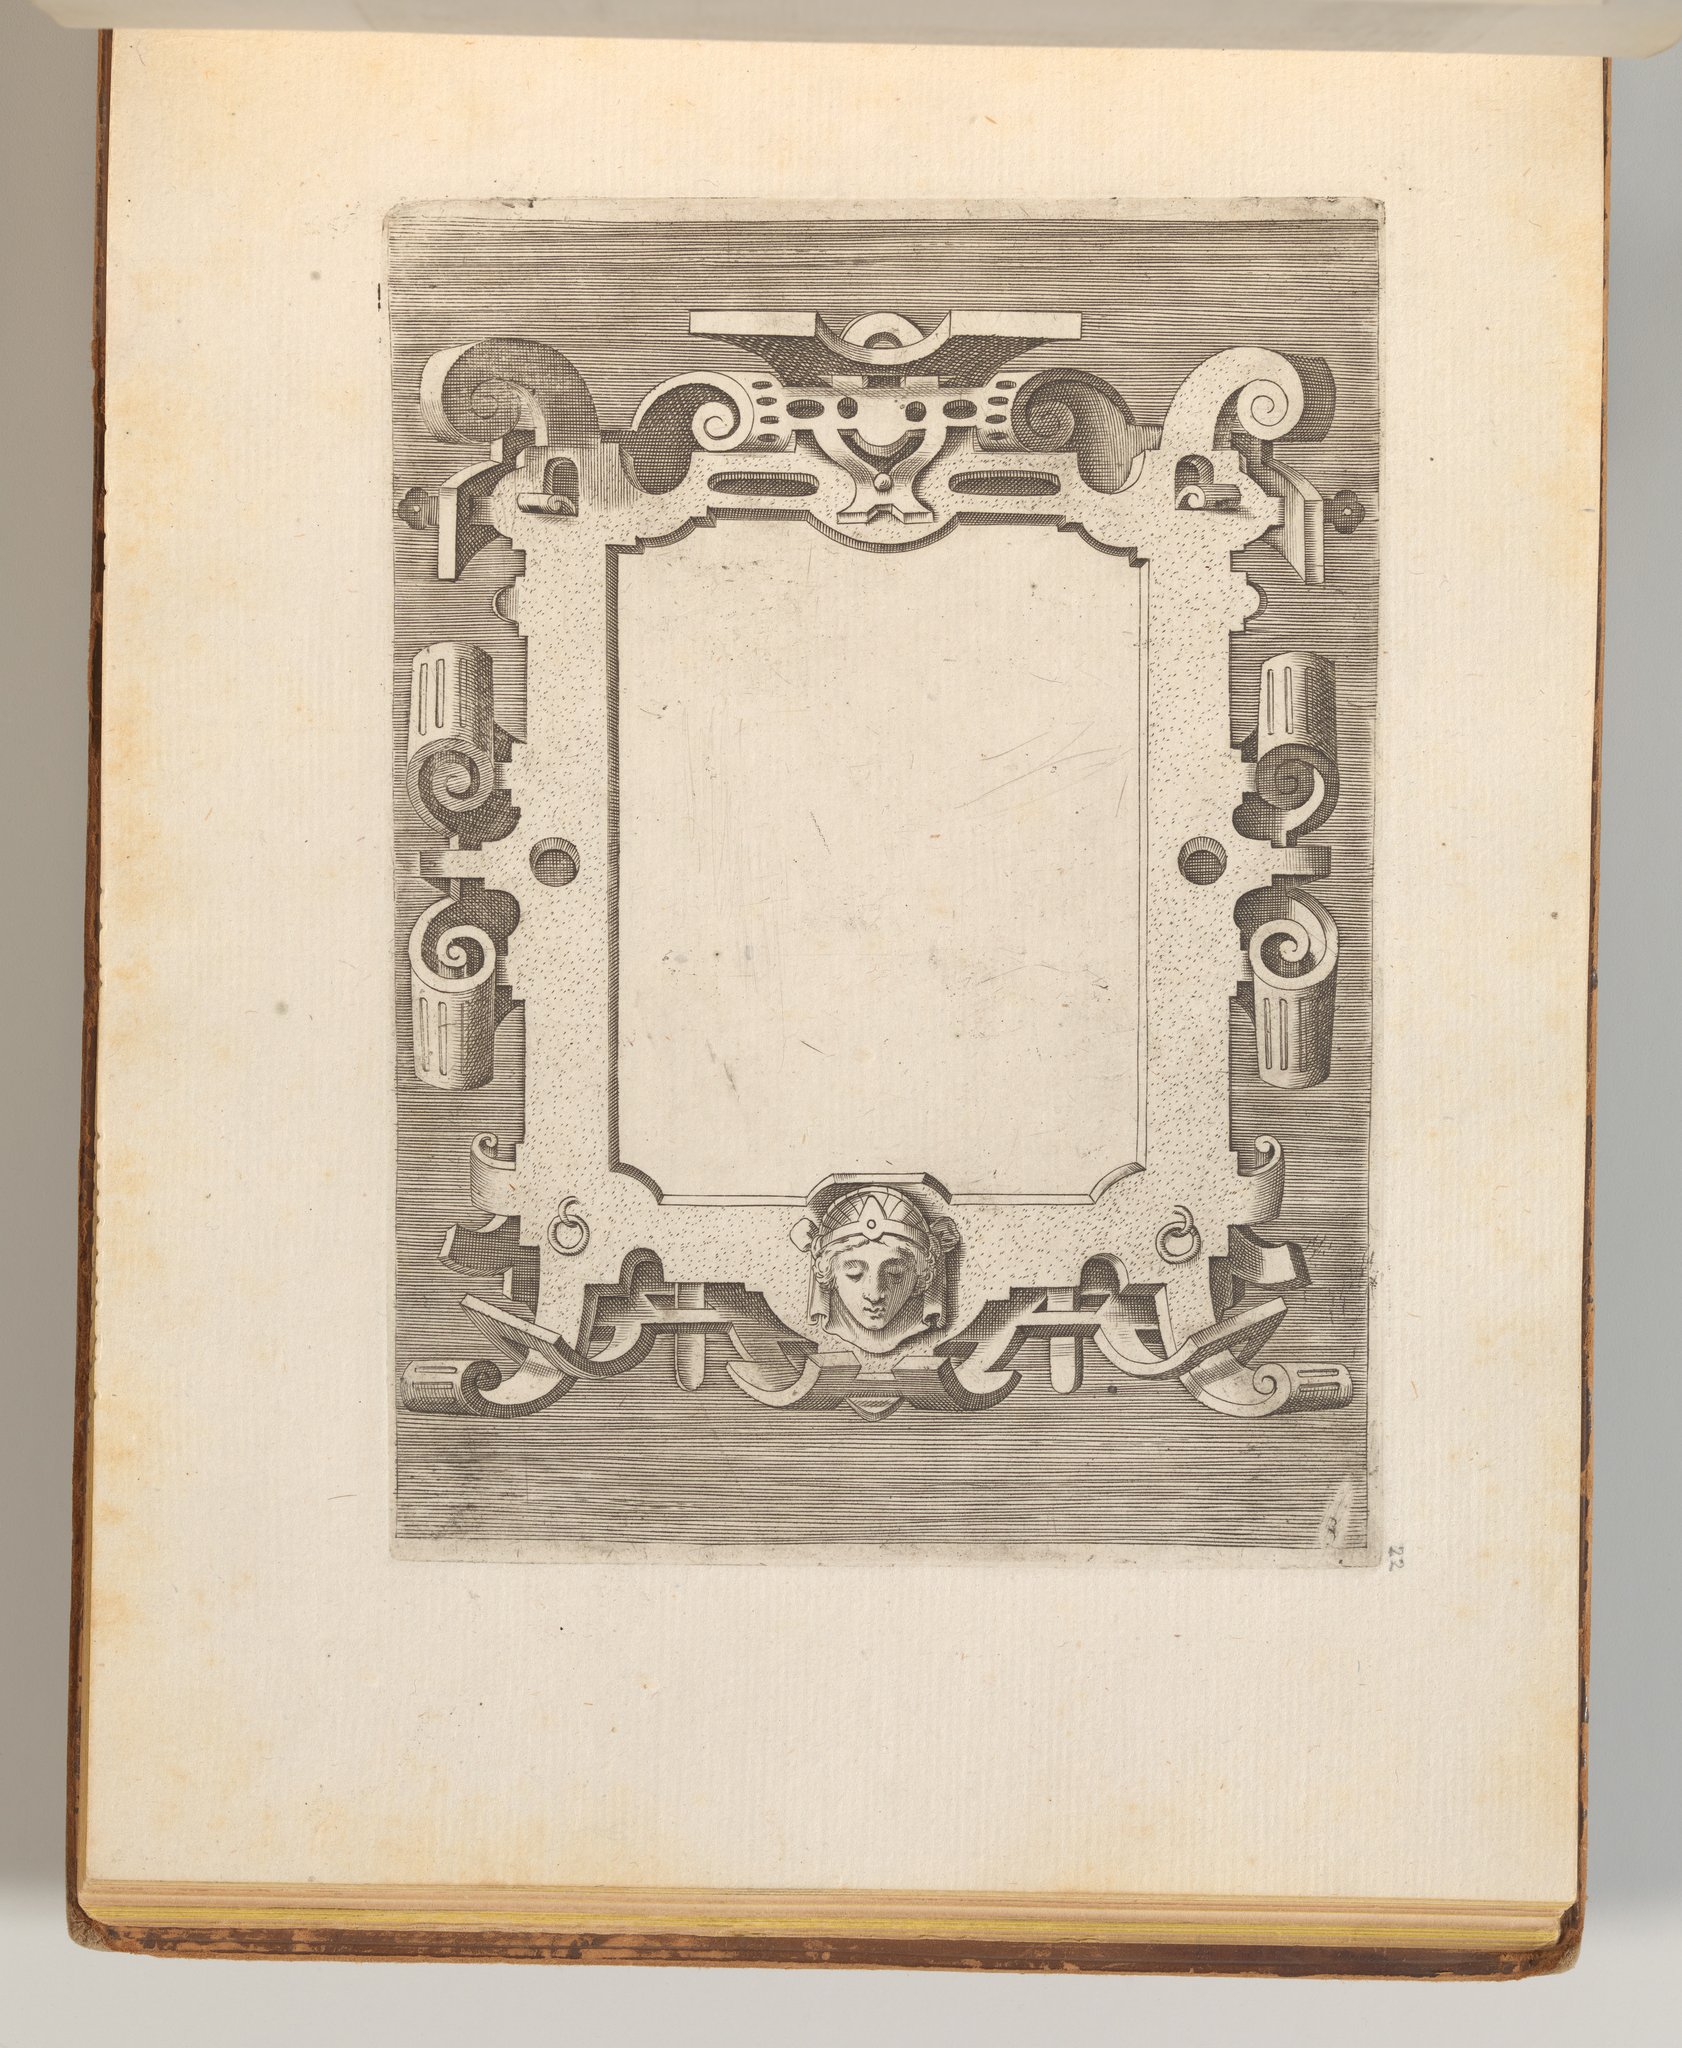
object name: album print ornament architecture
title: Targhe ed altri ornati di varie e capricciose invenzioni (Cartouches and other ornaments of various and capricious invention, page 27)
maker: hans vredeman de vries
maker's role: artist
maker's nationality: netherlandish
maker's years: 1527-1606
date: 1773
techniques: engraving, etching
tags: cartouches,faces